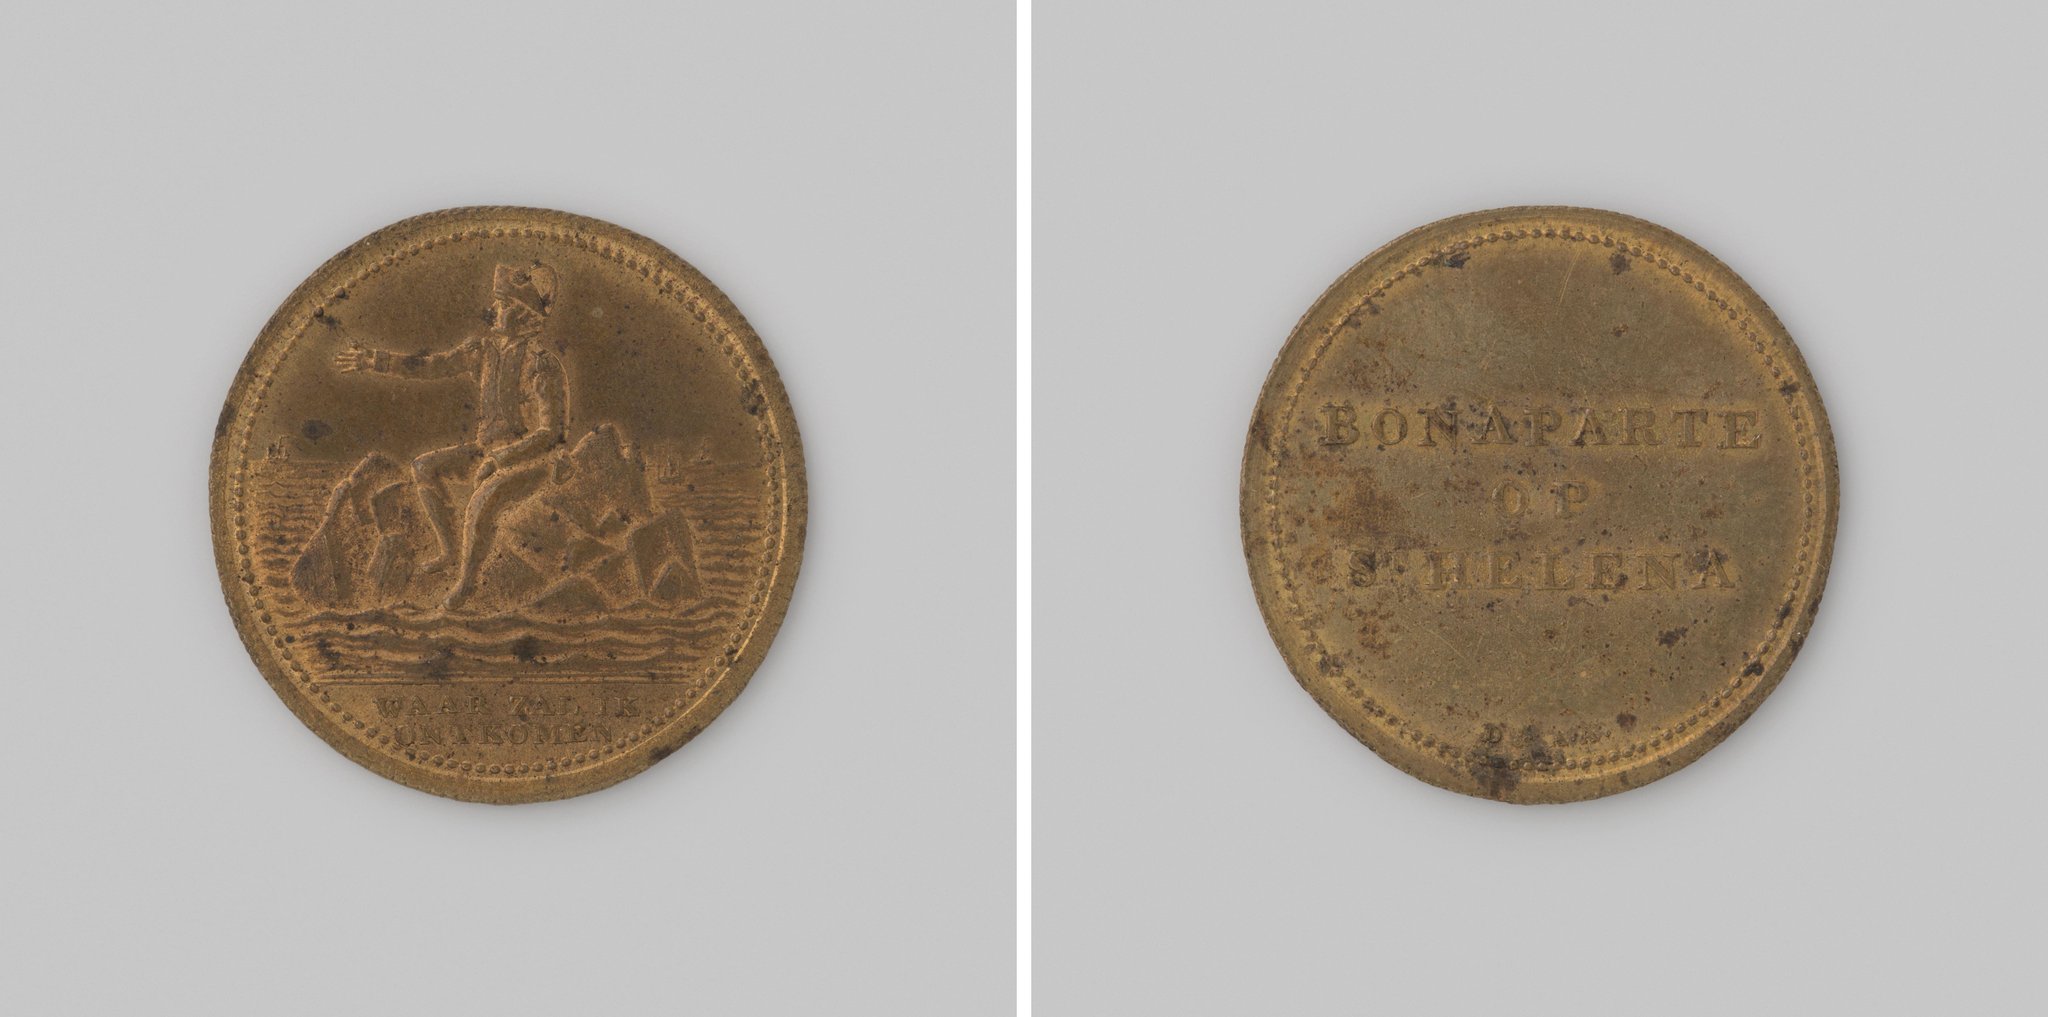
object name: history medal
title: Verbanning van Napoleon Bonaparte naar Sint Helena 1815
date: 1815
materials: brass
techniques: striking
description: Messing penning, op de voorzijde Napoleon zittend op een steenklomp op zee, met afsnedetekst, op de keerzijde drie regels tekst.